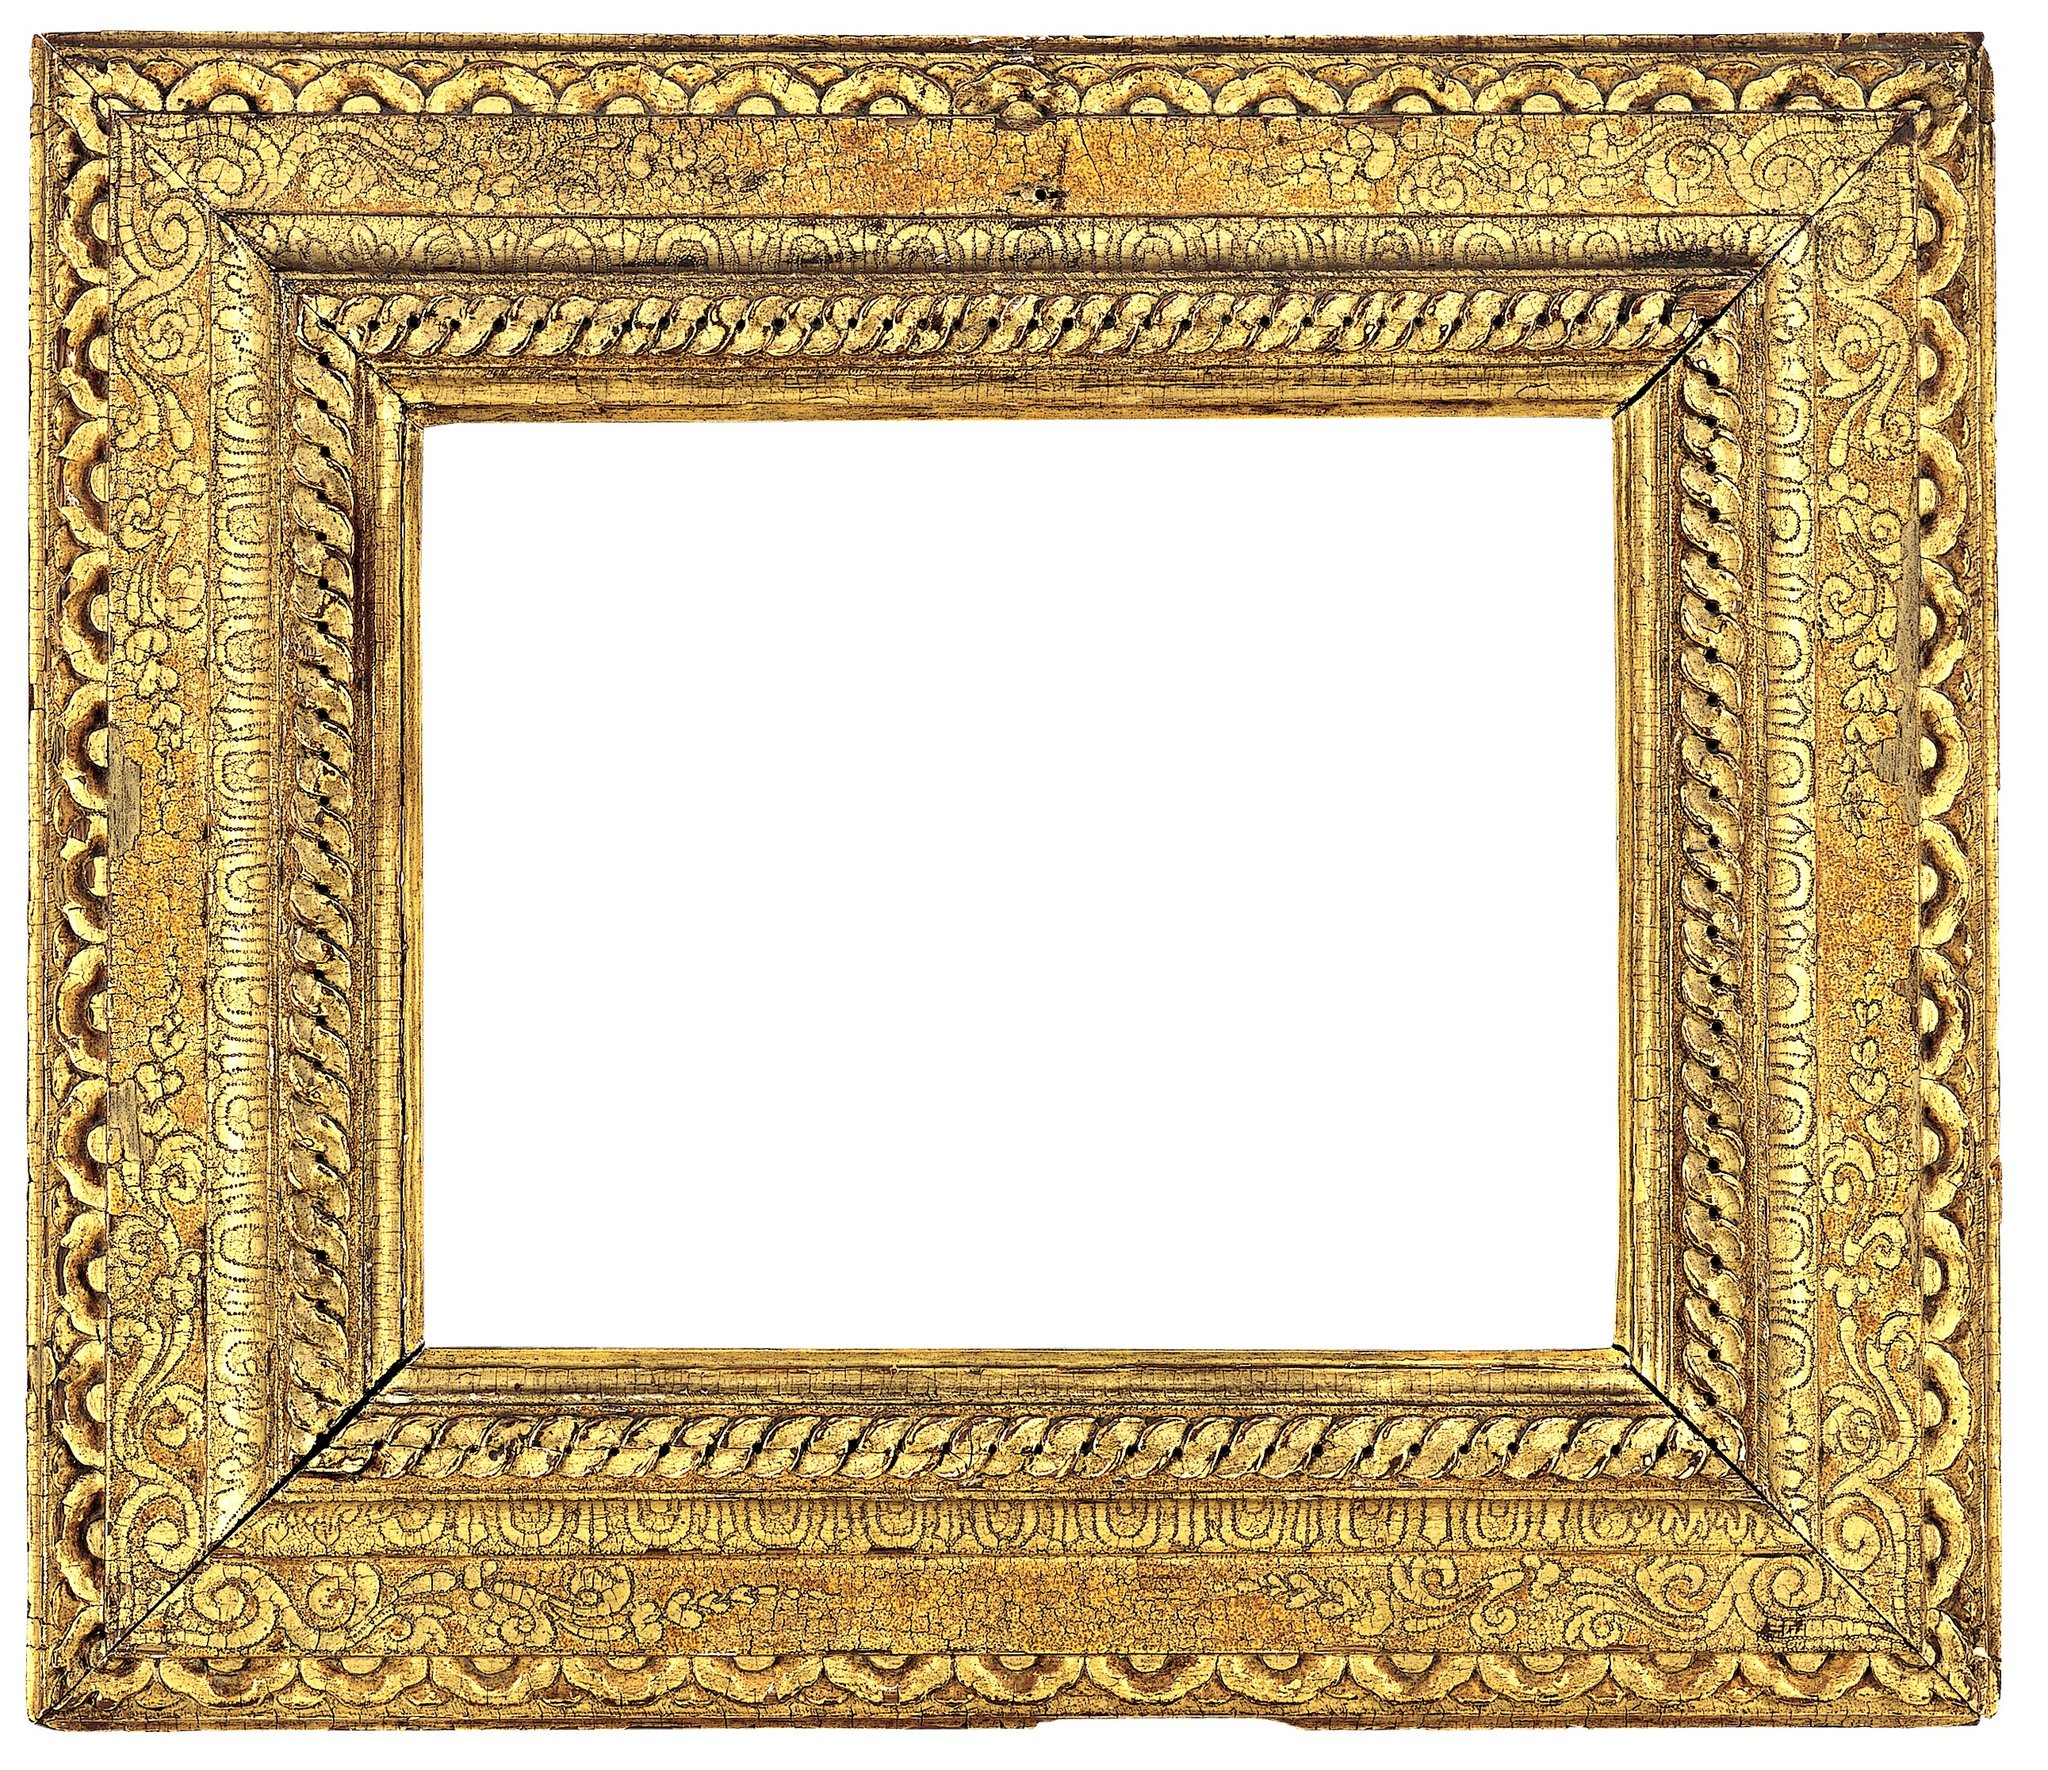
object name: frame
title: Reverse cassetta frame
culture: french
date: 1630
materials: gilt, wood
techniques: carving